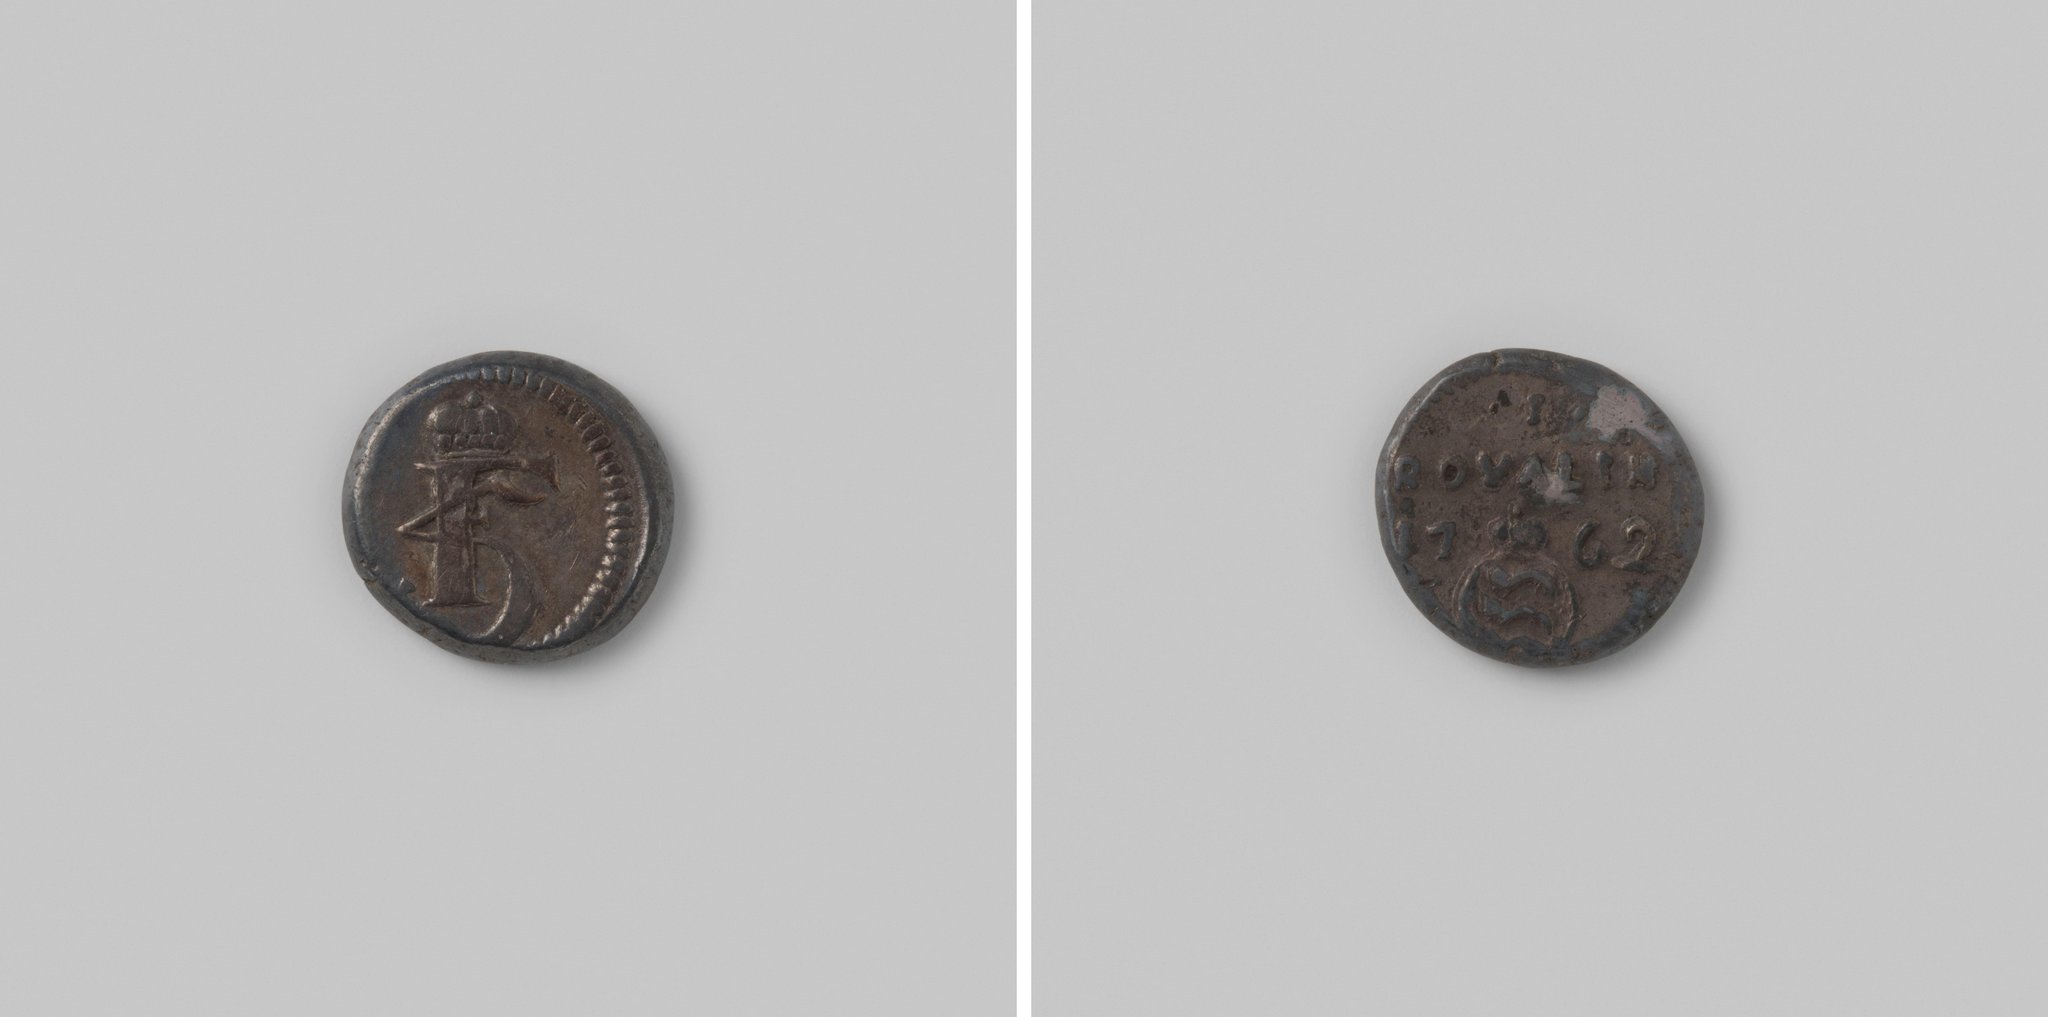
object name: coin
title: Tranquebar, Deens-India, Deense Aziatische Compagnie (DAC) op naam van koning Frederik V, royalin, 1762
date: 1762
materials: silver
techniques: striking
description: Zilveren munt. Voorzijde: gekroond monogram van de koning. Keerzijde: waarde-aanduiding: 1 royalin in twee regels. Daaronder tussen jaartal gekroond ovaal Deens wapenschild. Gladde rand.